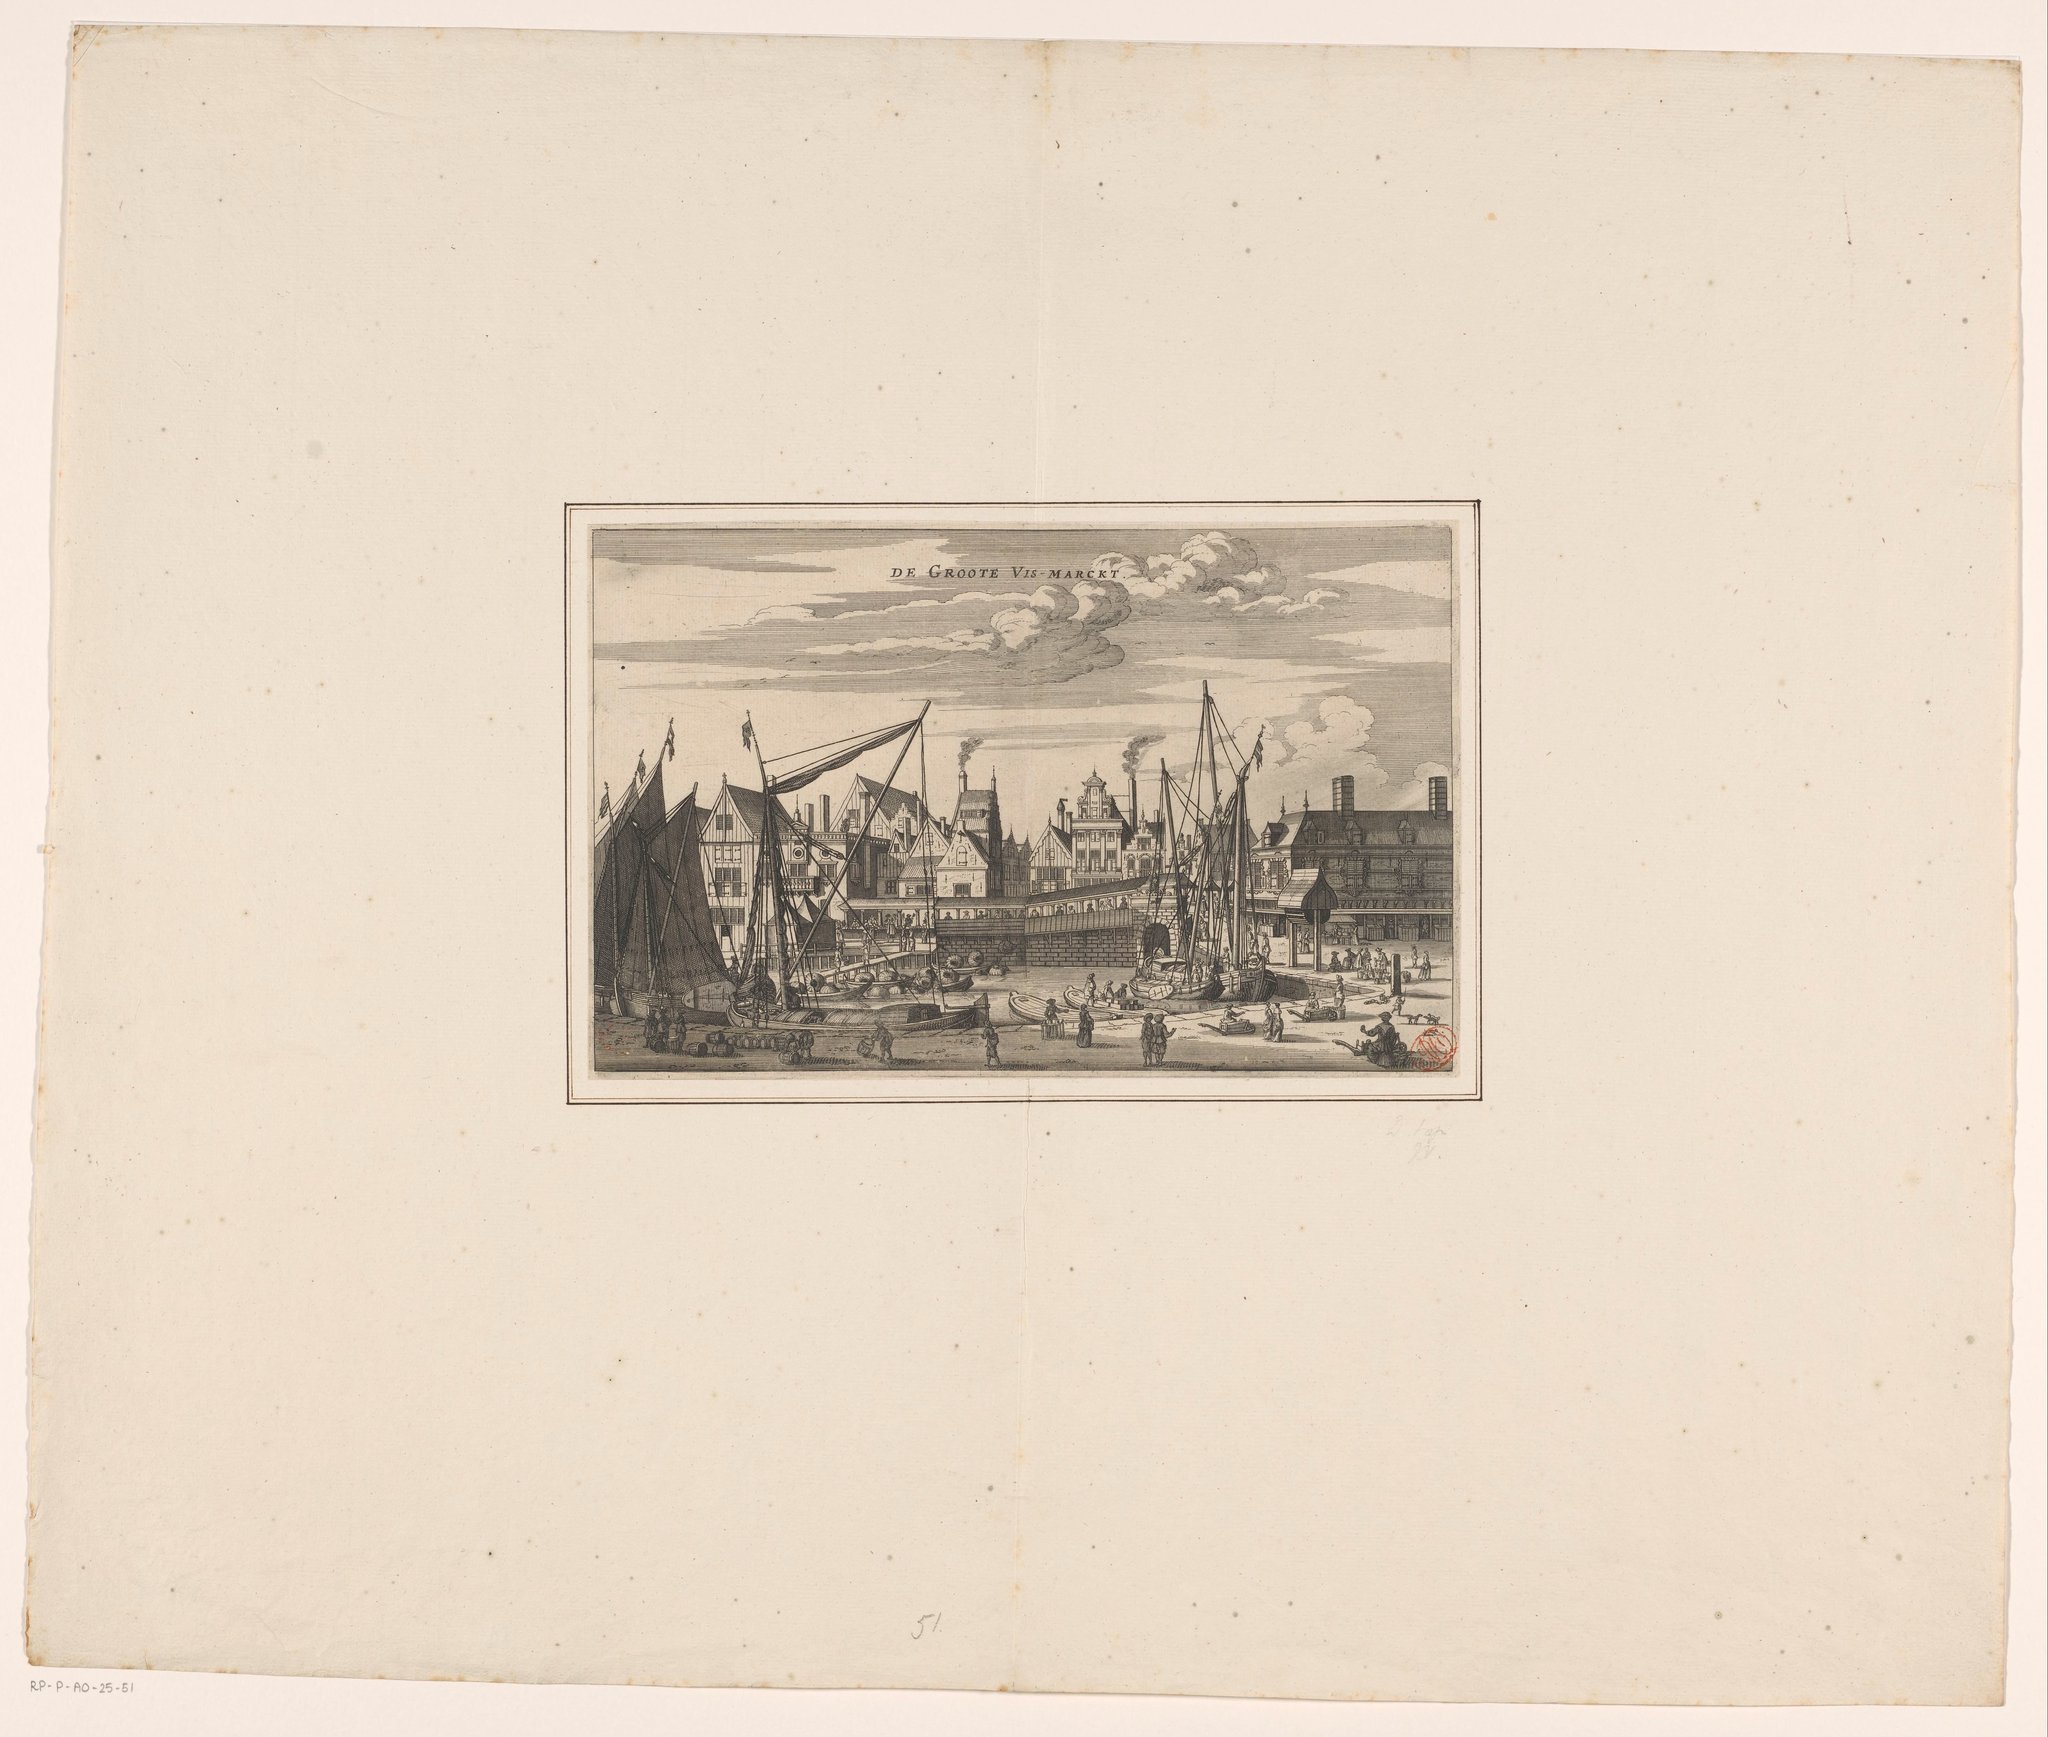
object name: print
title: De Groote Vis-marckt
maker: jacob van meurs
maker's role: draughtsman, print maker, publisher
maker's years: 1619-1680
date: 1663-1664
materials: paper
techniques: engraving, etching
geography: amsterdam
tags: fishes, stall, booth (~ market), market, square, place, circus, etc. (+ city(-scape) with figures, staffage), street (+ city(-scape) with figures, staffage)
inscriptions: collector's mark: Lugt 195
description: Huidige staat van prent ook gebruikt in: Dapper, Olfert. Historische beschryving der stadt Amsterdam: waer in de voornaemste geschiedenissen (na een kort verhael van gansch Hollant en d'omleggende dorpen (…). Amsterdam: Jacob van Meurs, 1663.* En in: Zesen, Philipp von. Beschreibung der Stadt Amsterdam: darinnen von derselben ersten Ursprunge bis auf gegenwärtigen Zustand (…). Amsterdam: Joachim Nosche, 1664. * In sommige exemplaren van deze uitgave komt de huidige staat van de prent voor. In andere exemplaren is een latere staat ingebonden, waarop boven de Nederlandse een Franse titel is toegevoegd.